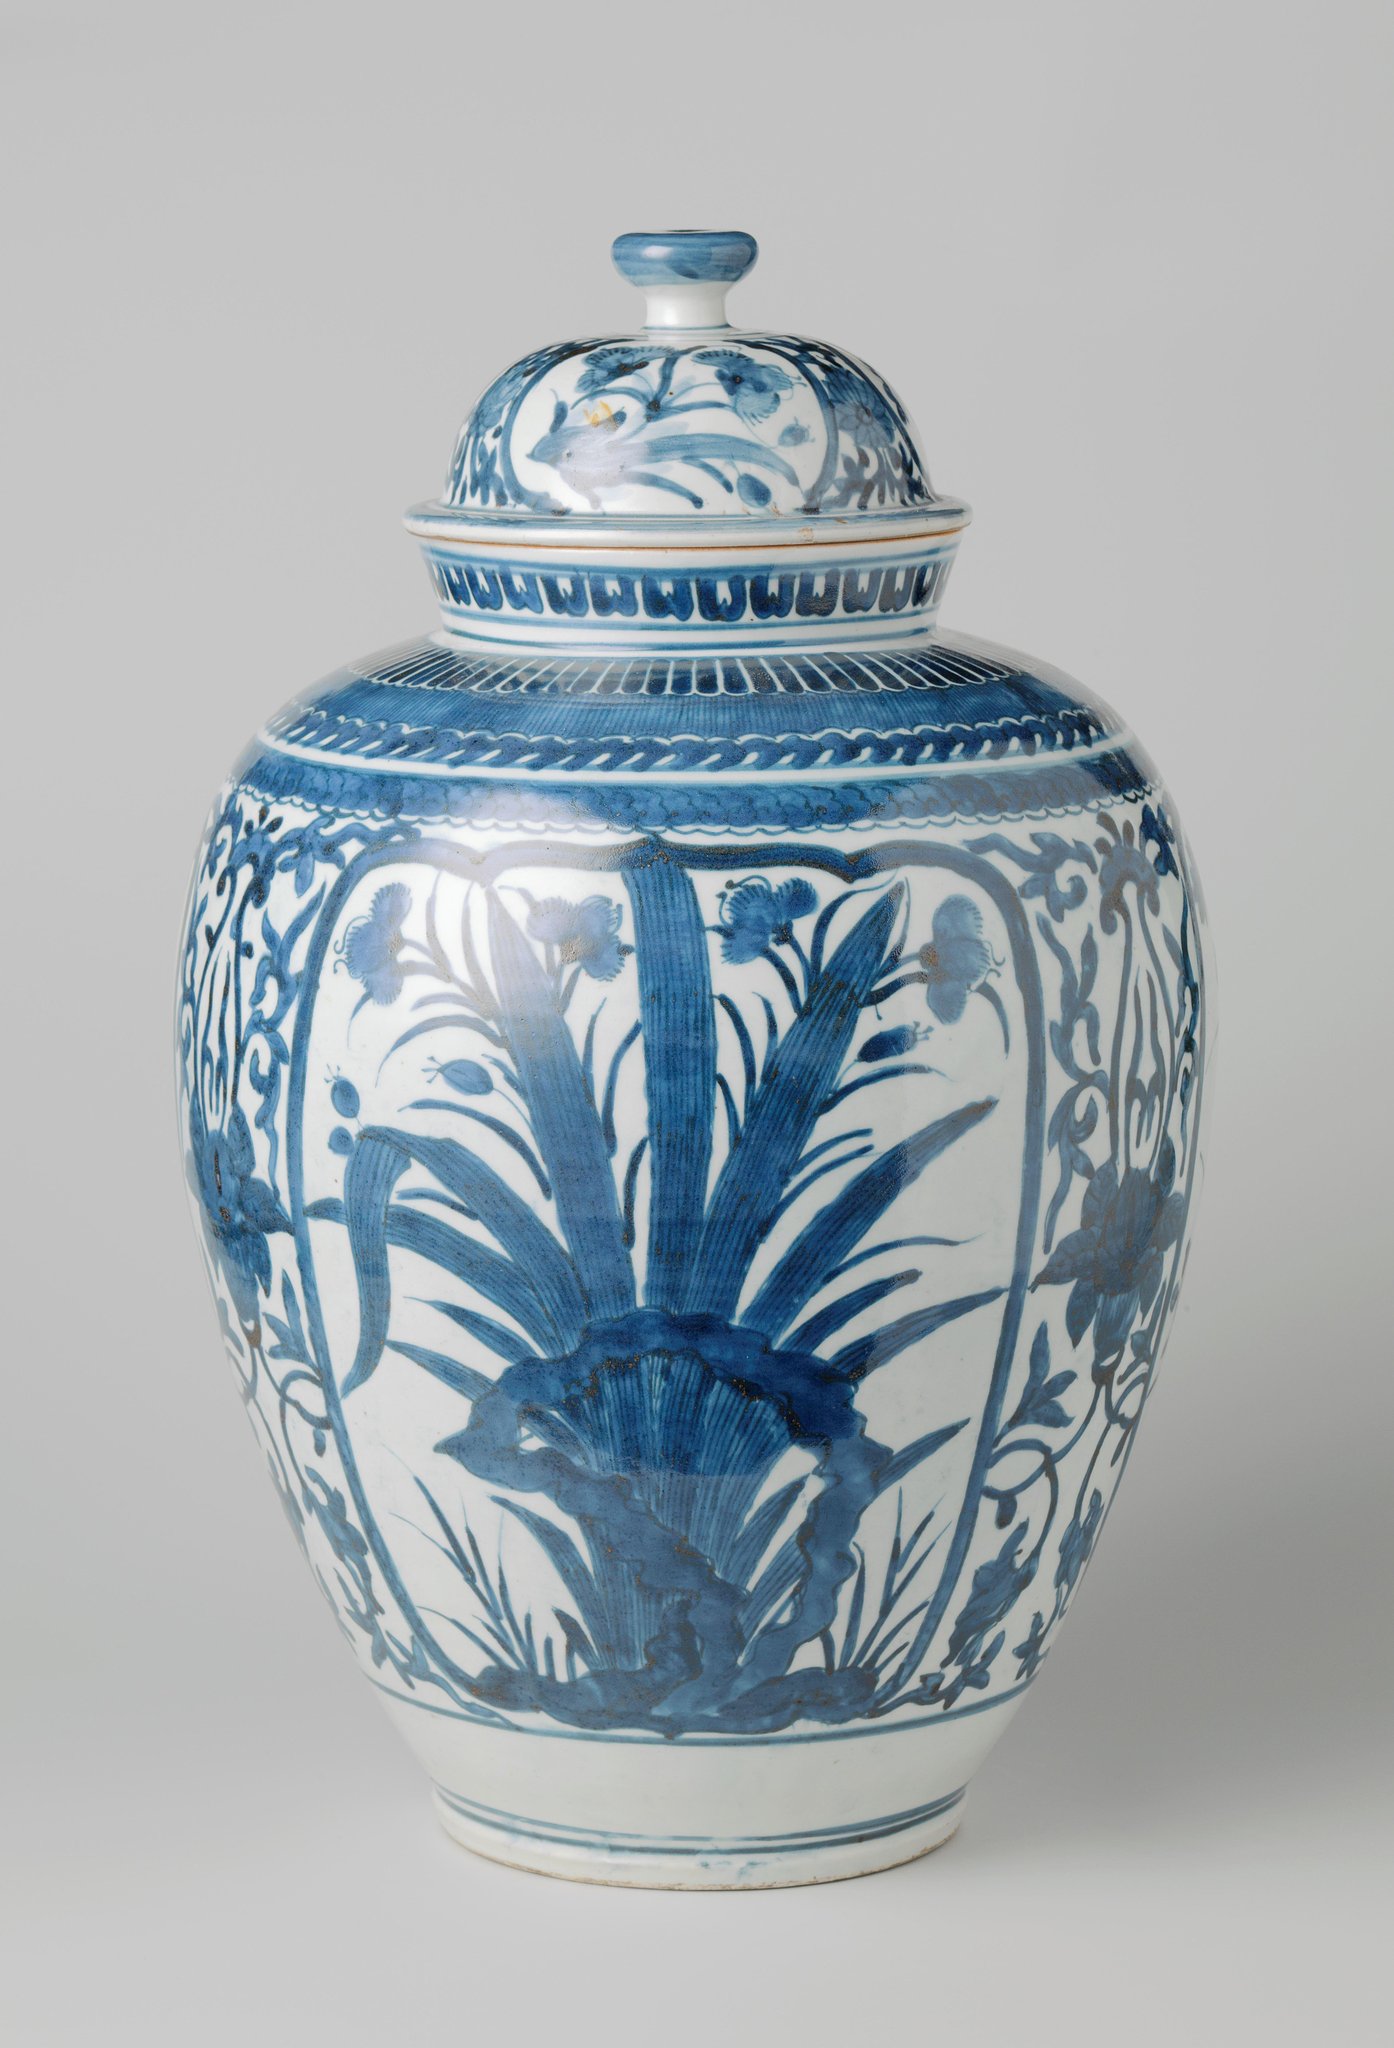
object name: covered jar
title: Ovoid covered jar with flowering plants near rocks and lotus scrolls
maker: Anonymous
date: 1675-1699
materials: cobalt, glaze, paint, porcelain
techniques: firing, turning, vitrification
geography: japan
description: Deksel van eivormige dekselpot van porselein, beschilderd in onderglazuur blauw. Op de wand drie geschulpte cartouches met bloeiende planten (pioen, iris, chrysant, lotus) bij een rots. Tussen de cartouches een lotusrank. Op de dekselknop een gestileerde bloem. Blauw-wit.